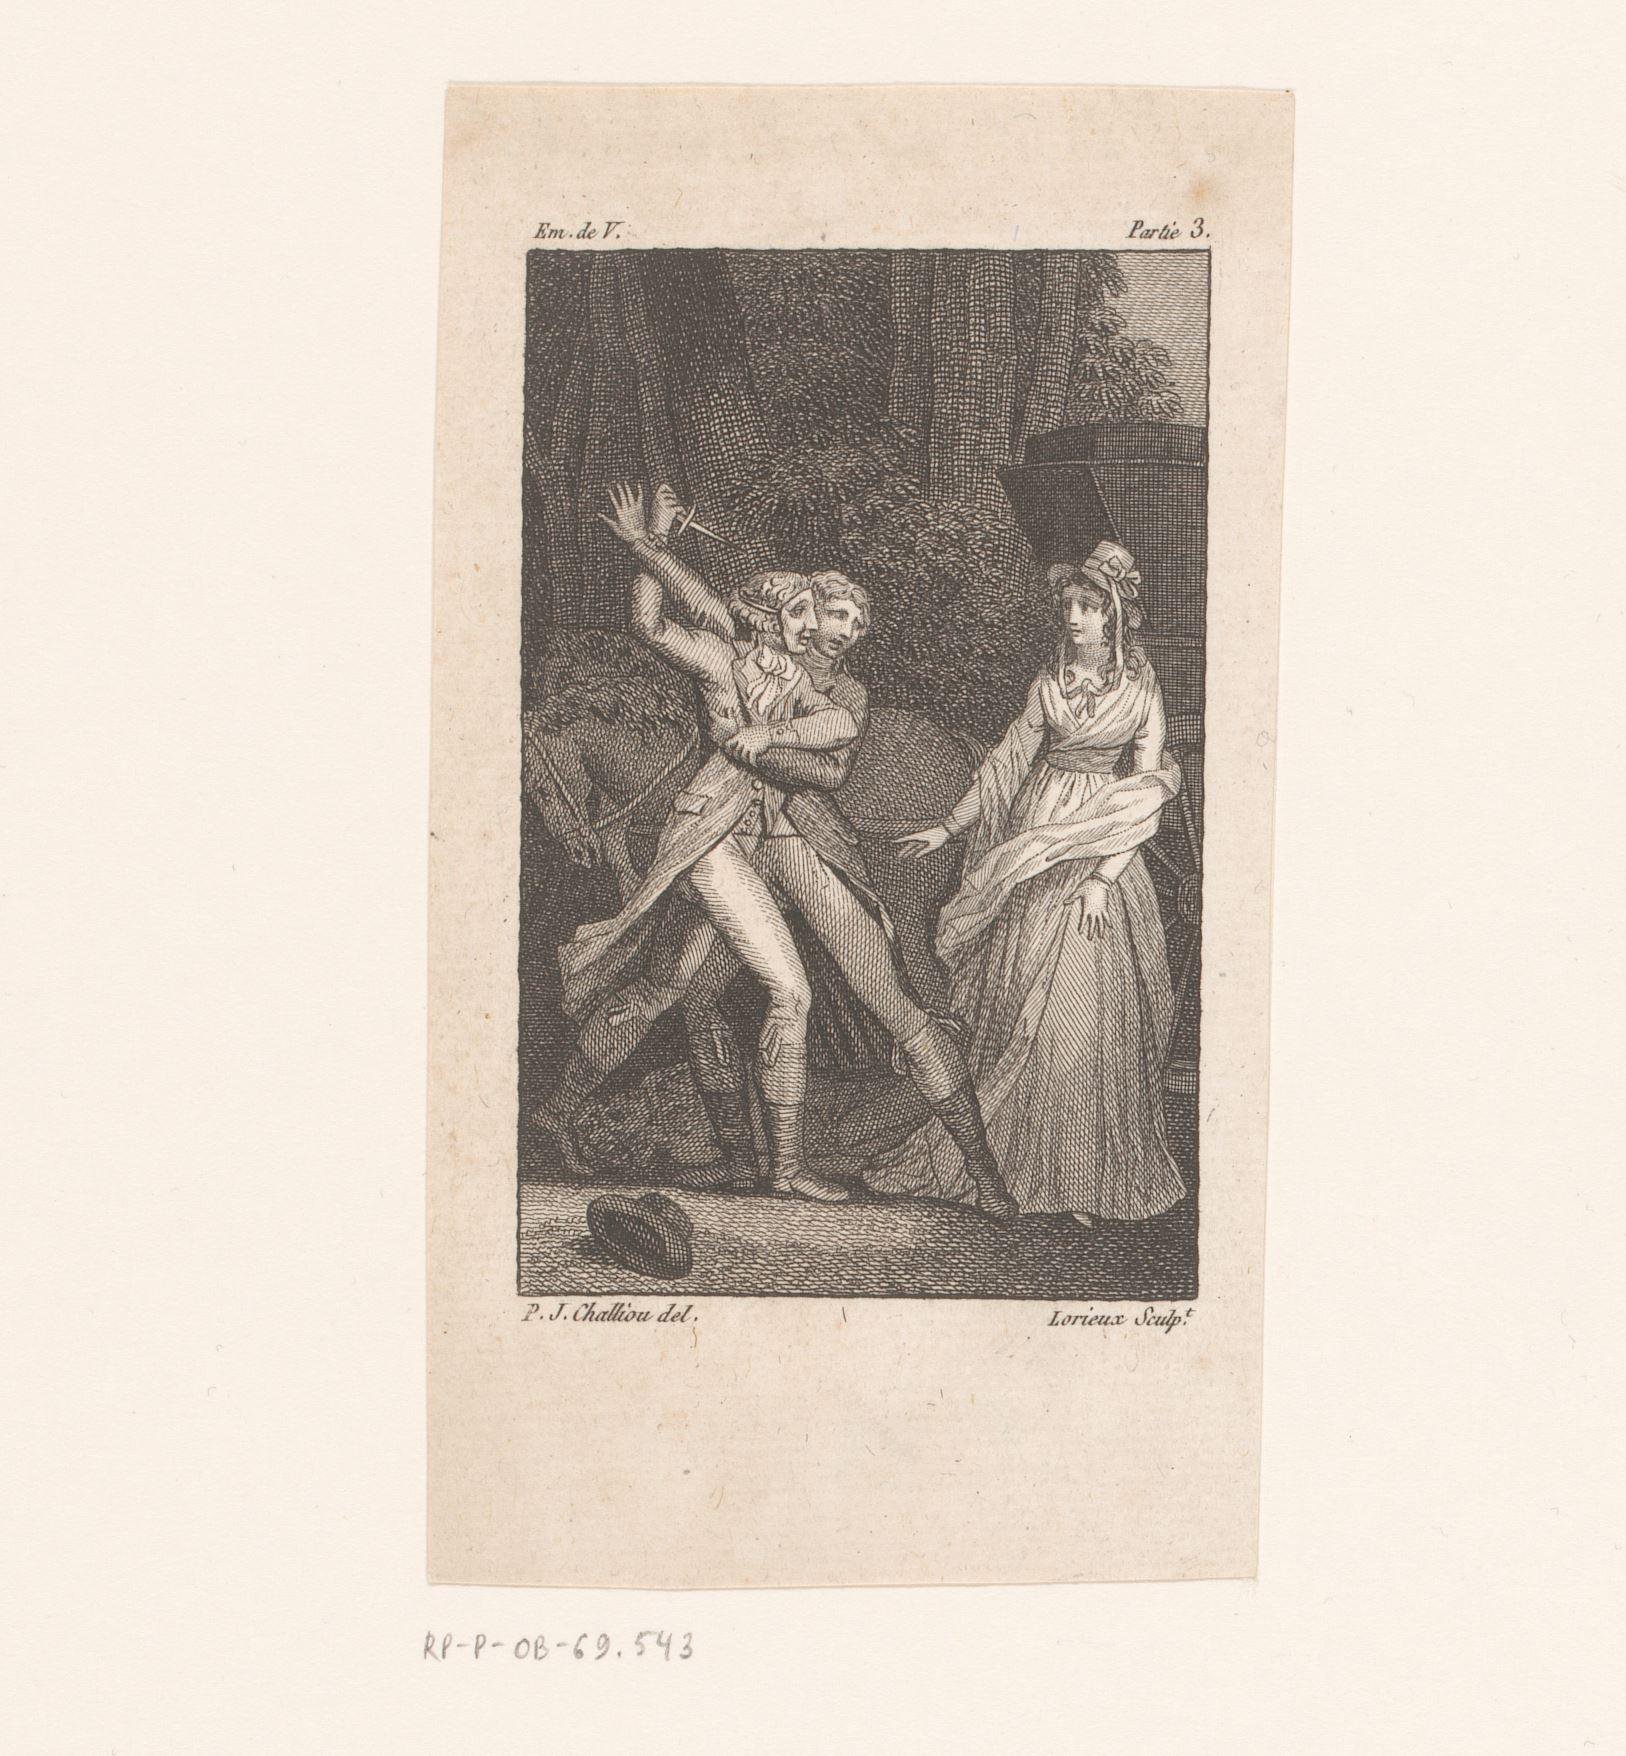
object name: print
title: Verhindering van een aanslag op een vrouw door een gemaskerde man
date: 1791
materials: paper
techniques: etching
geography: france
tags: mask, being attacked; defence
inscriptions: inscription: ‘[...] libris L.A. Lighten [...]’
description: Mogelijk prent uit: Louvet de Couvray, Jean-Baptiste. Les amours et les galanteries du chevalier De Faublas. Parijs: M. Louvet de Couvray, 1791 of een later geïllustreerde editie.